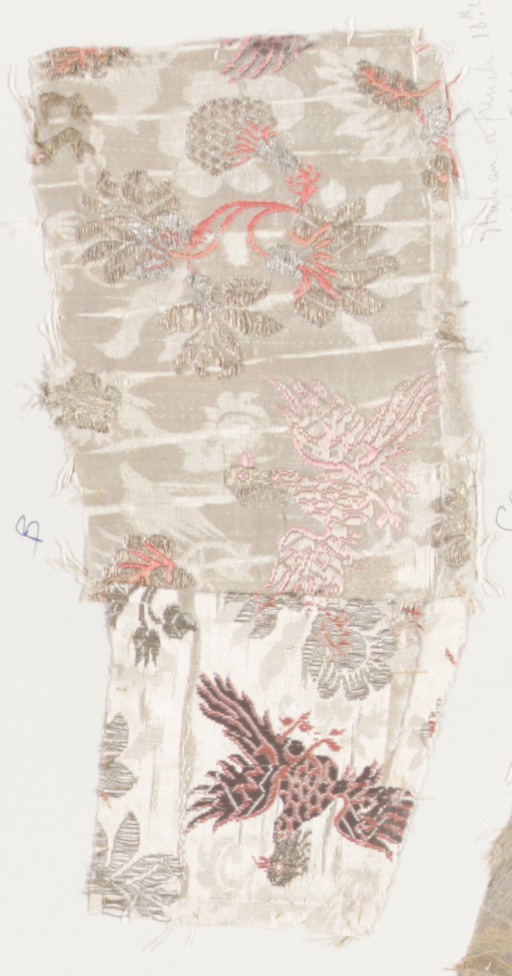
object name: fragment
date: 1601-1800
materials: metal thread, silk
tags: birds,flowers